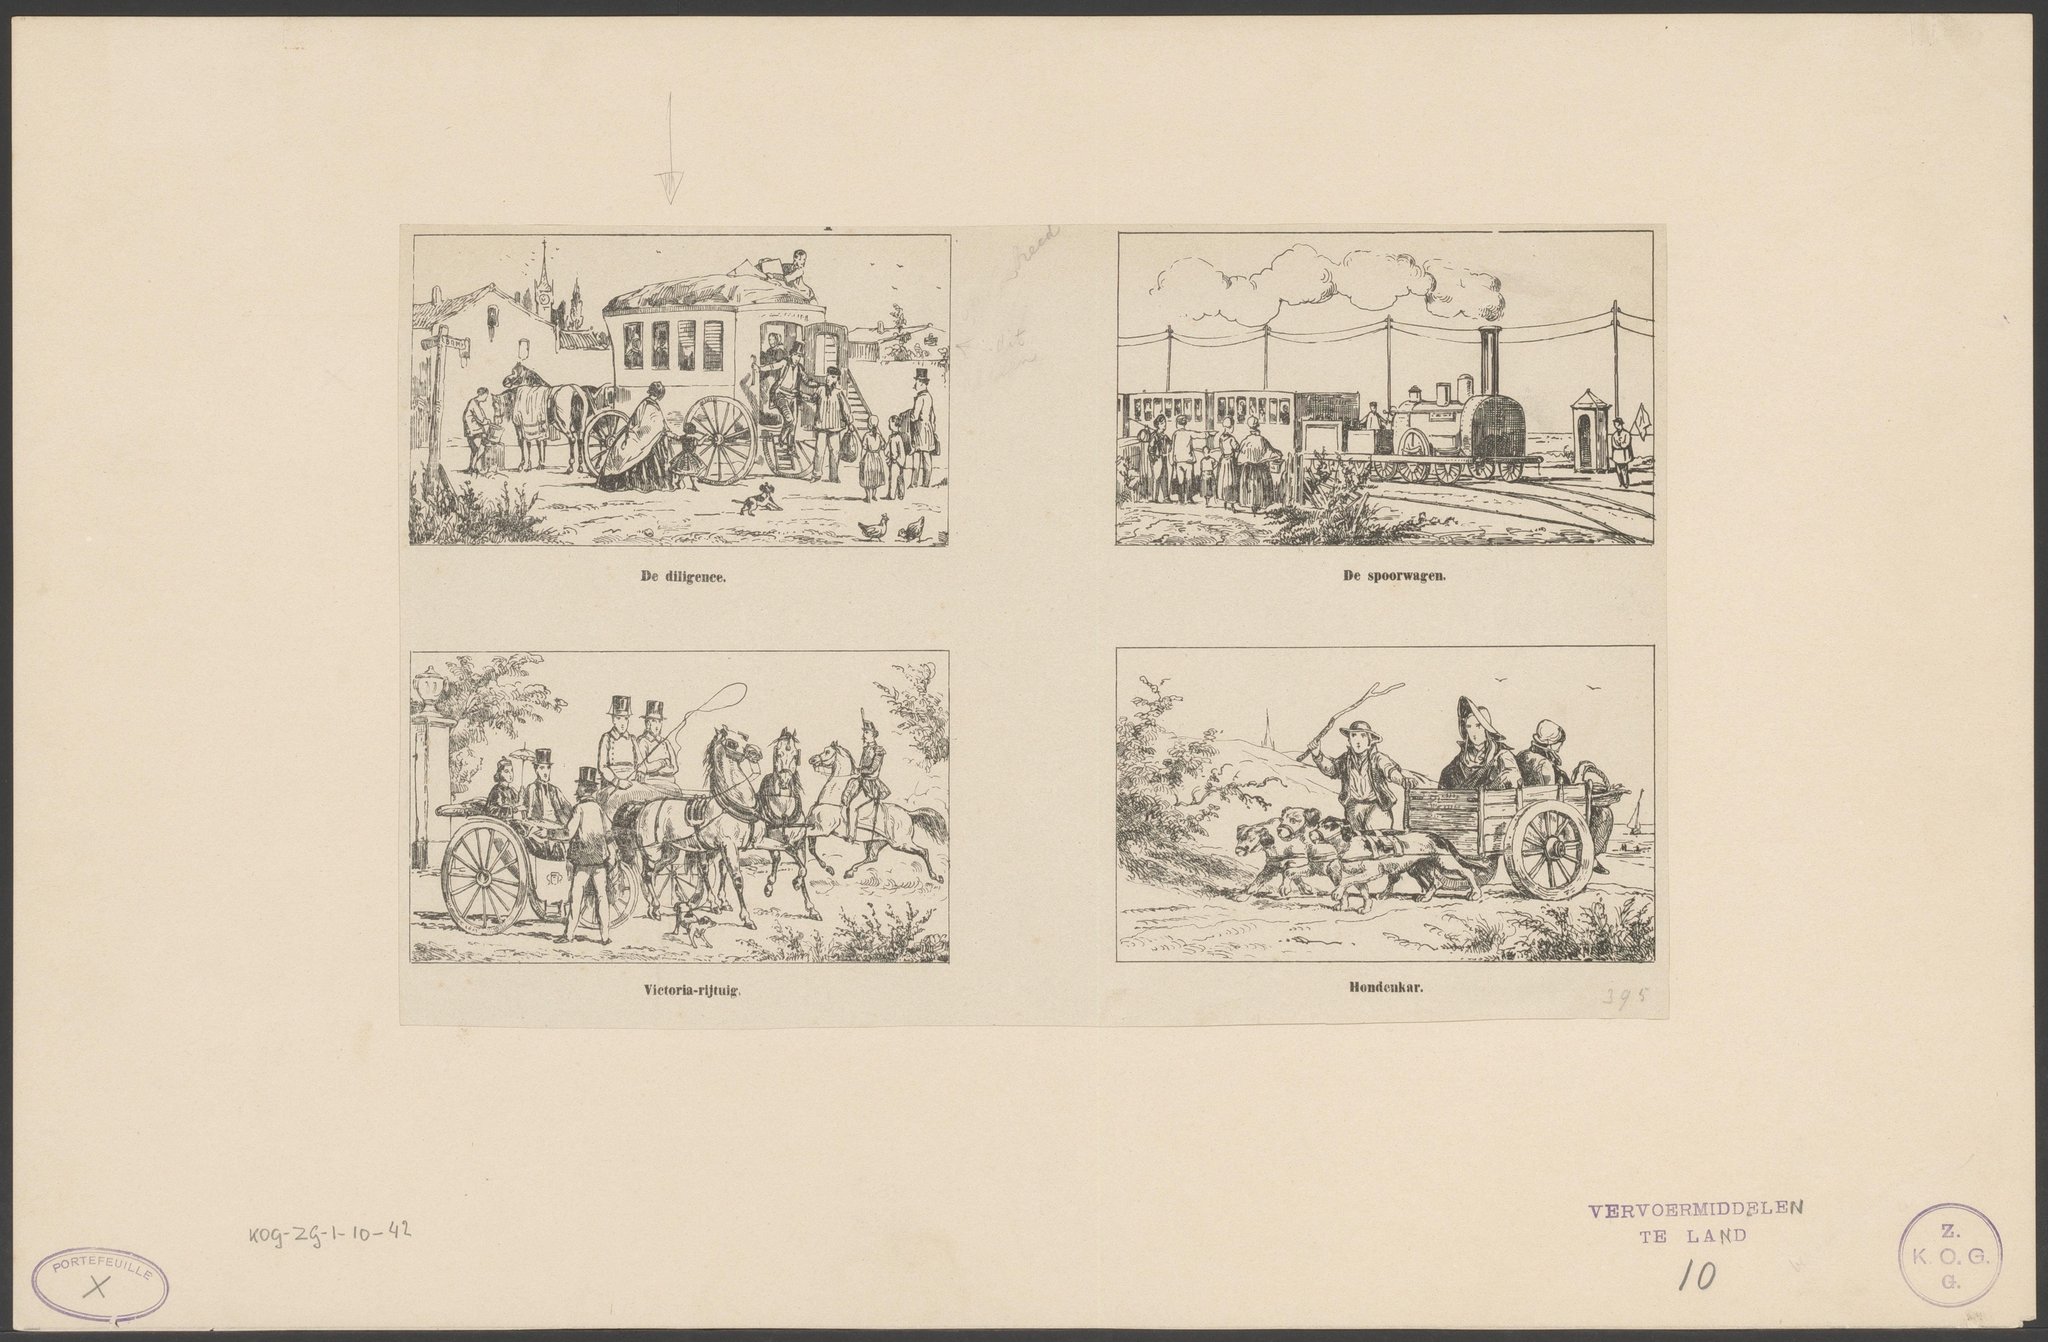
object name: print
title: Vier verschillende vormen van personenvervoer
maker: Anonymous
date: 1839-1899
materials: paper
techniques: lithograph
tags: railway-traffic, dog-sleigh, two-wheeled, animal-drawn vehicle, horse, two-wheeled vehicle drawn by more than three animals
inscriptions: stamp, stamp, collector's mark: Lugt 1641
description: Vier verschillende vervoersmiddelen voor personen: diligence, spoorwagen, Victoria-rijtuig en een hondenkar. Onderwerpsrubrieken binnen de Atlas Zeden en Gewoonten: Vervoermiddelen te land en te water, Vervoermiddelen te land, Reiskoetsen en post.